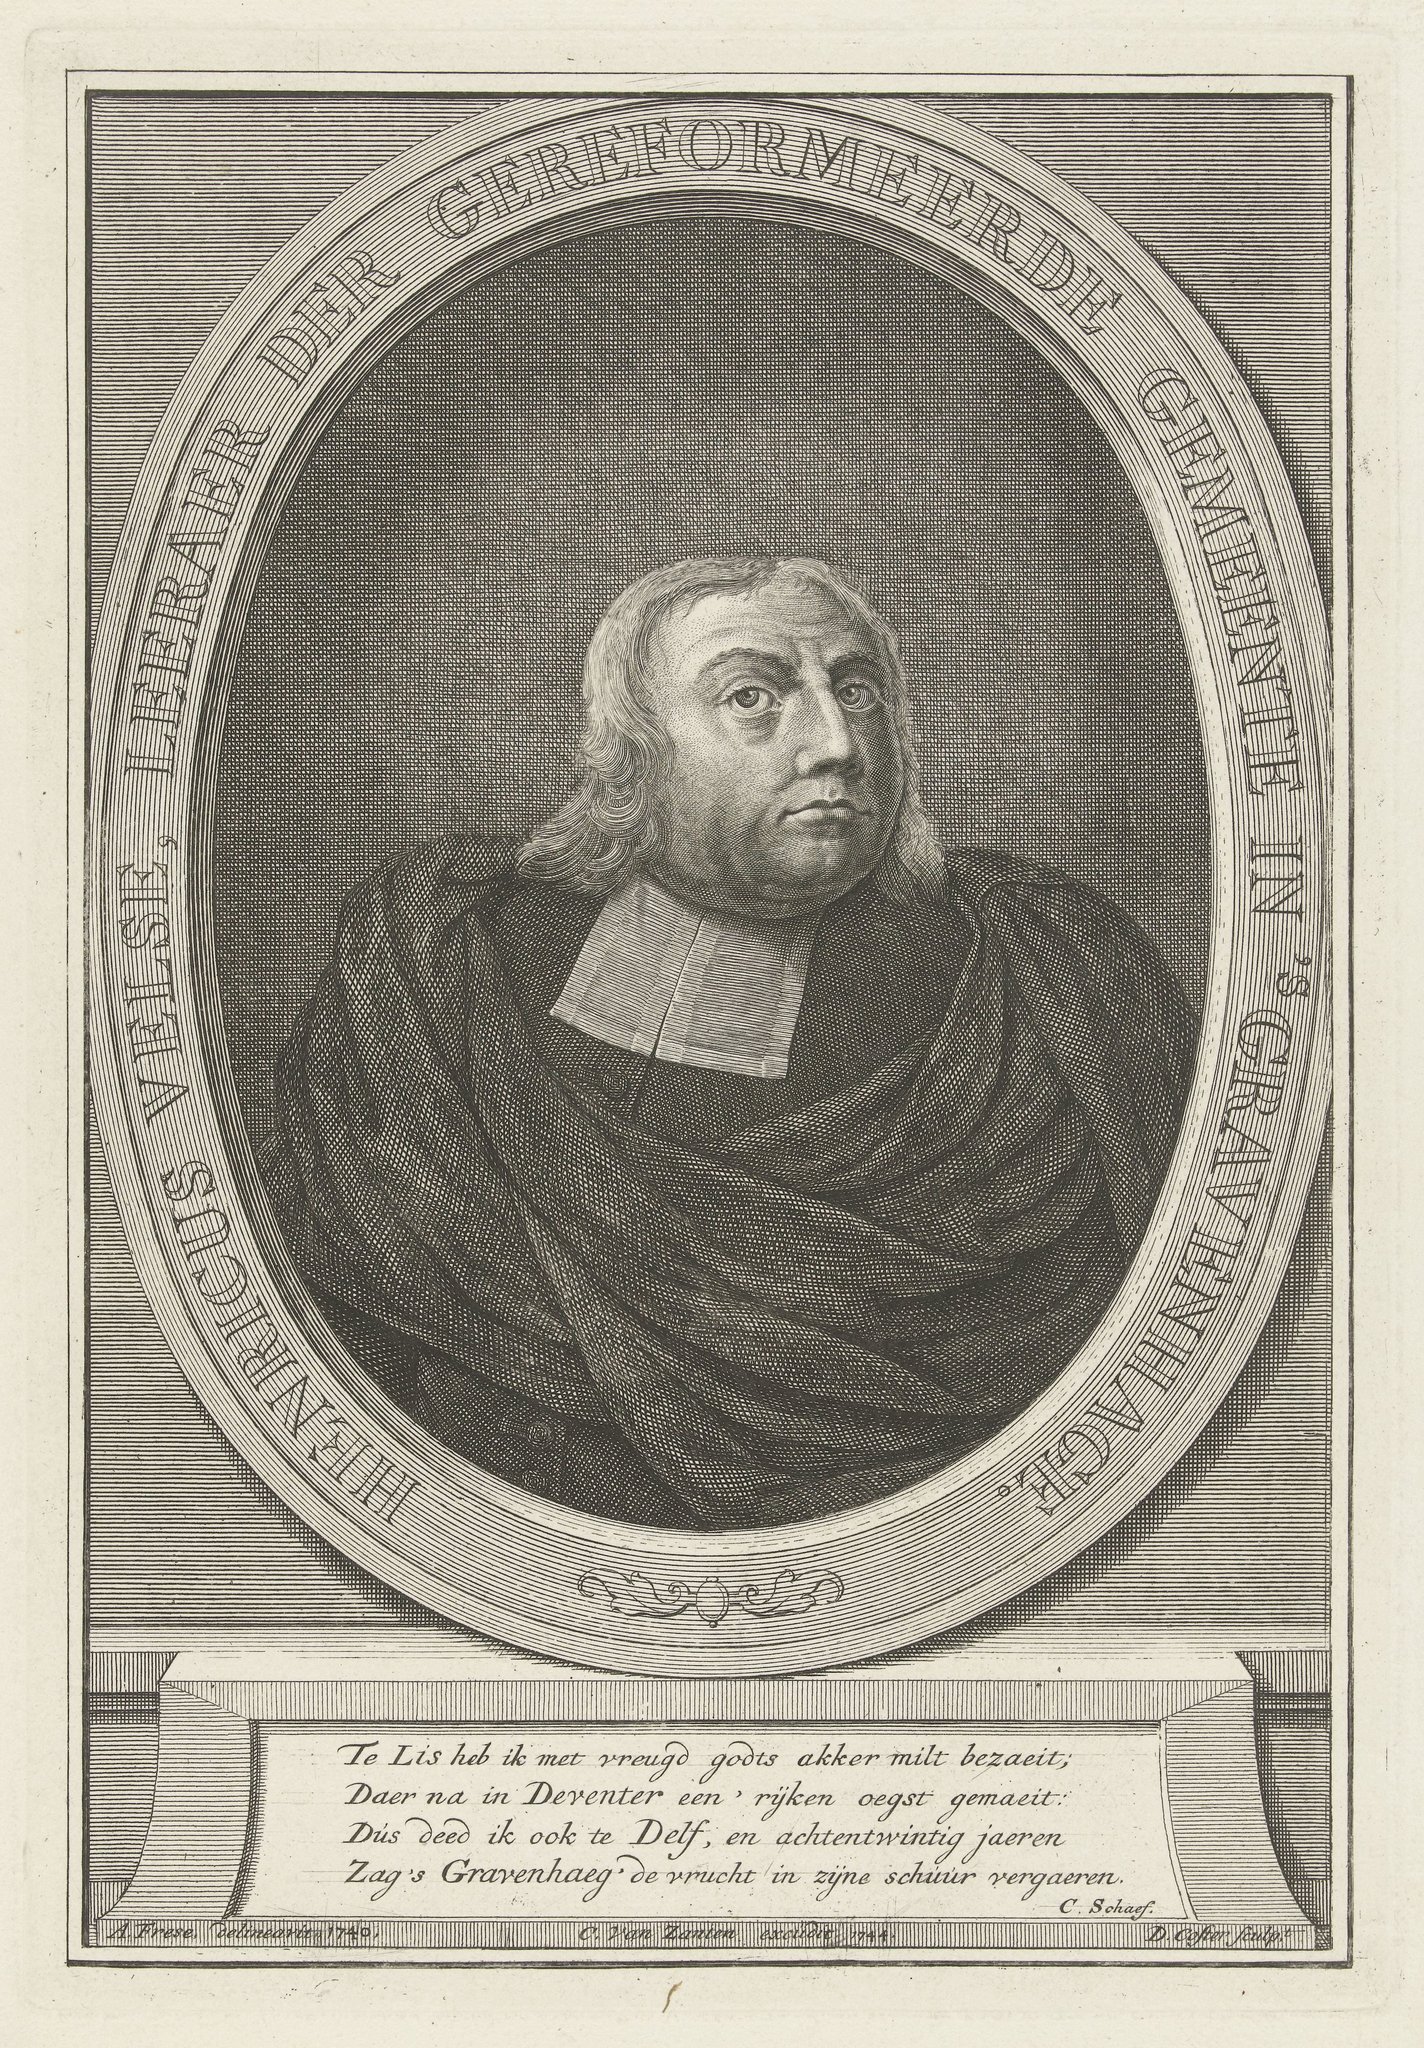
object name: print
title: Portret van Henricus Velsen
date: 1744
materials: paper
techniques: engraving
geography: the hague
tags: functionaries and dignitaries ~ protestant churches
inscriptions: collector's mark: Lugt 2228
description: Portret van Henricus Velsen, predikant van de gereformeerde gemeente te Den Haag, in ovaal met randschrift. Onder het portret een gedicht door C. Schaef.